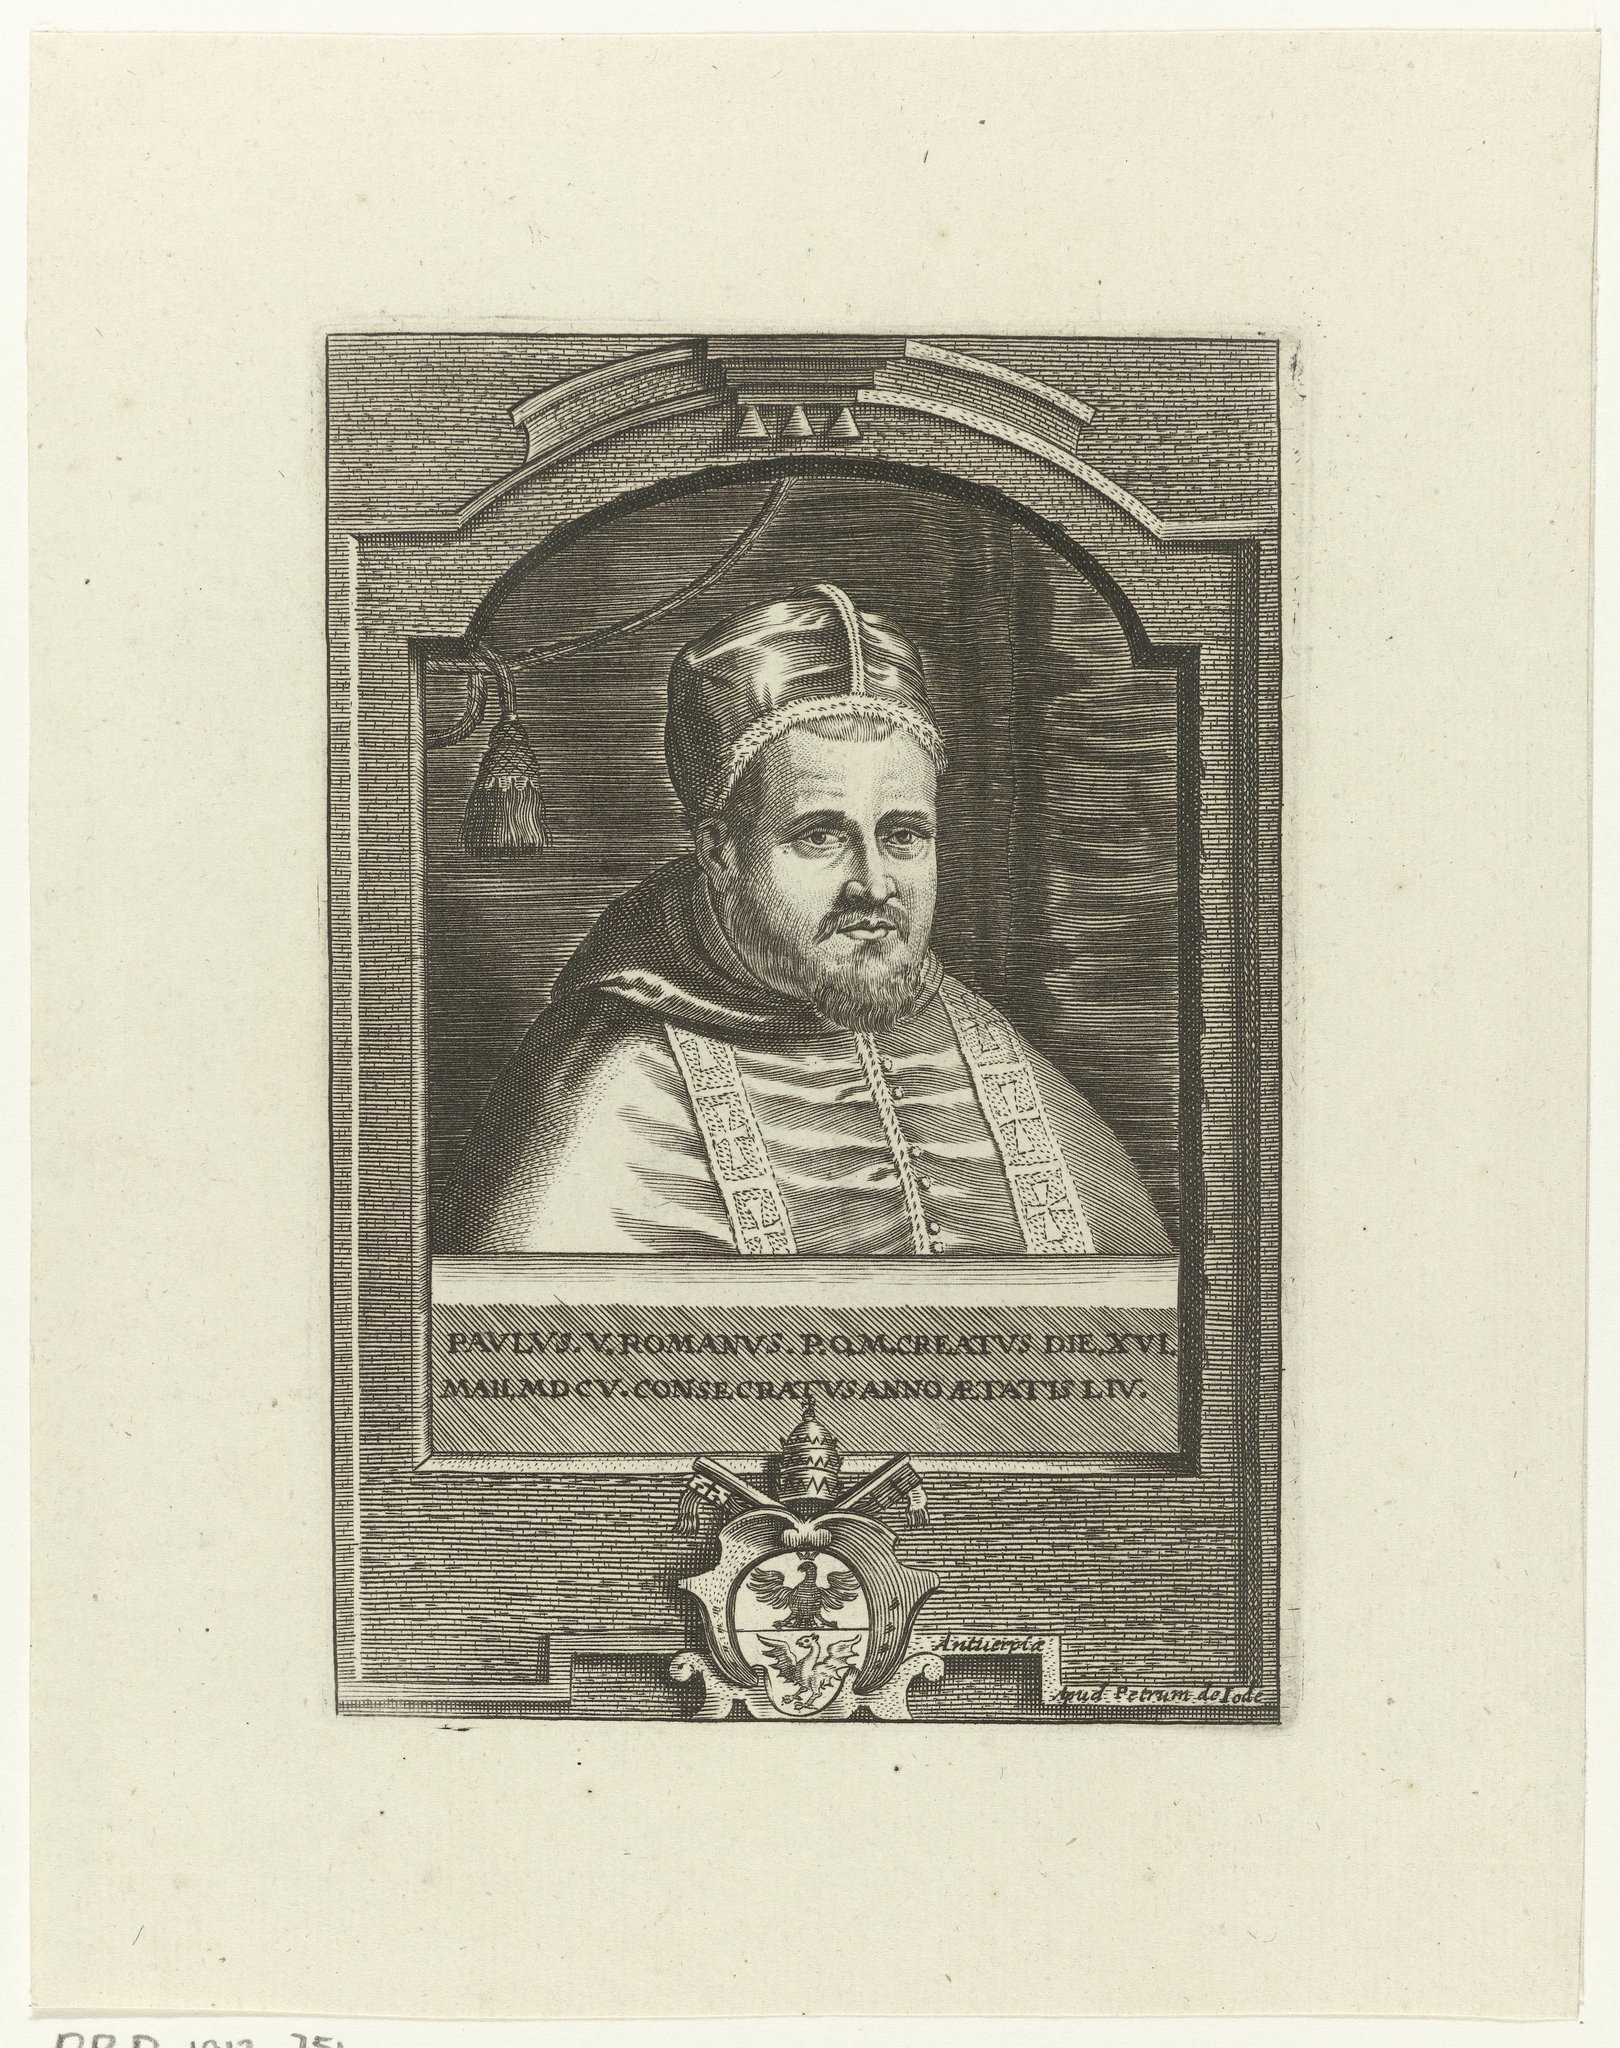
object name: print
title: Portret van paus Paulus V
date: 1628-1670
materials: paper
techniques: engraving, etching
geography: antwerp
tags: paulus v, head-gear (camauro) (+ men's clothes)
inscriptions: collector's mark: Lugt 2228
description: Busteportret van paus Paulus V op 54-jarige leeftijd, met camauro. Het portret is gevat in een boogvormige omlijsting met het wapenschild van de geportretteerde en een kader met een tweeregelig onderschrift in het Latijn.